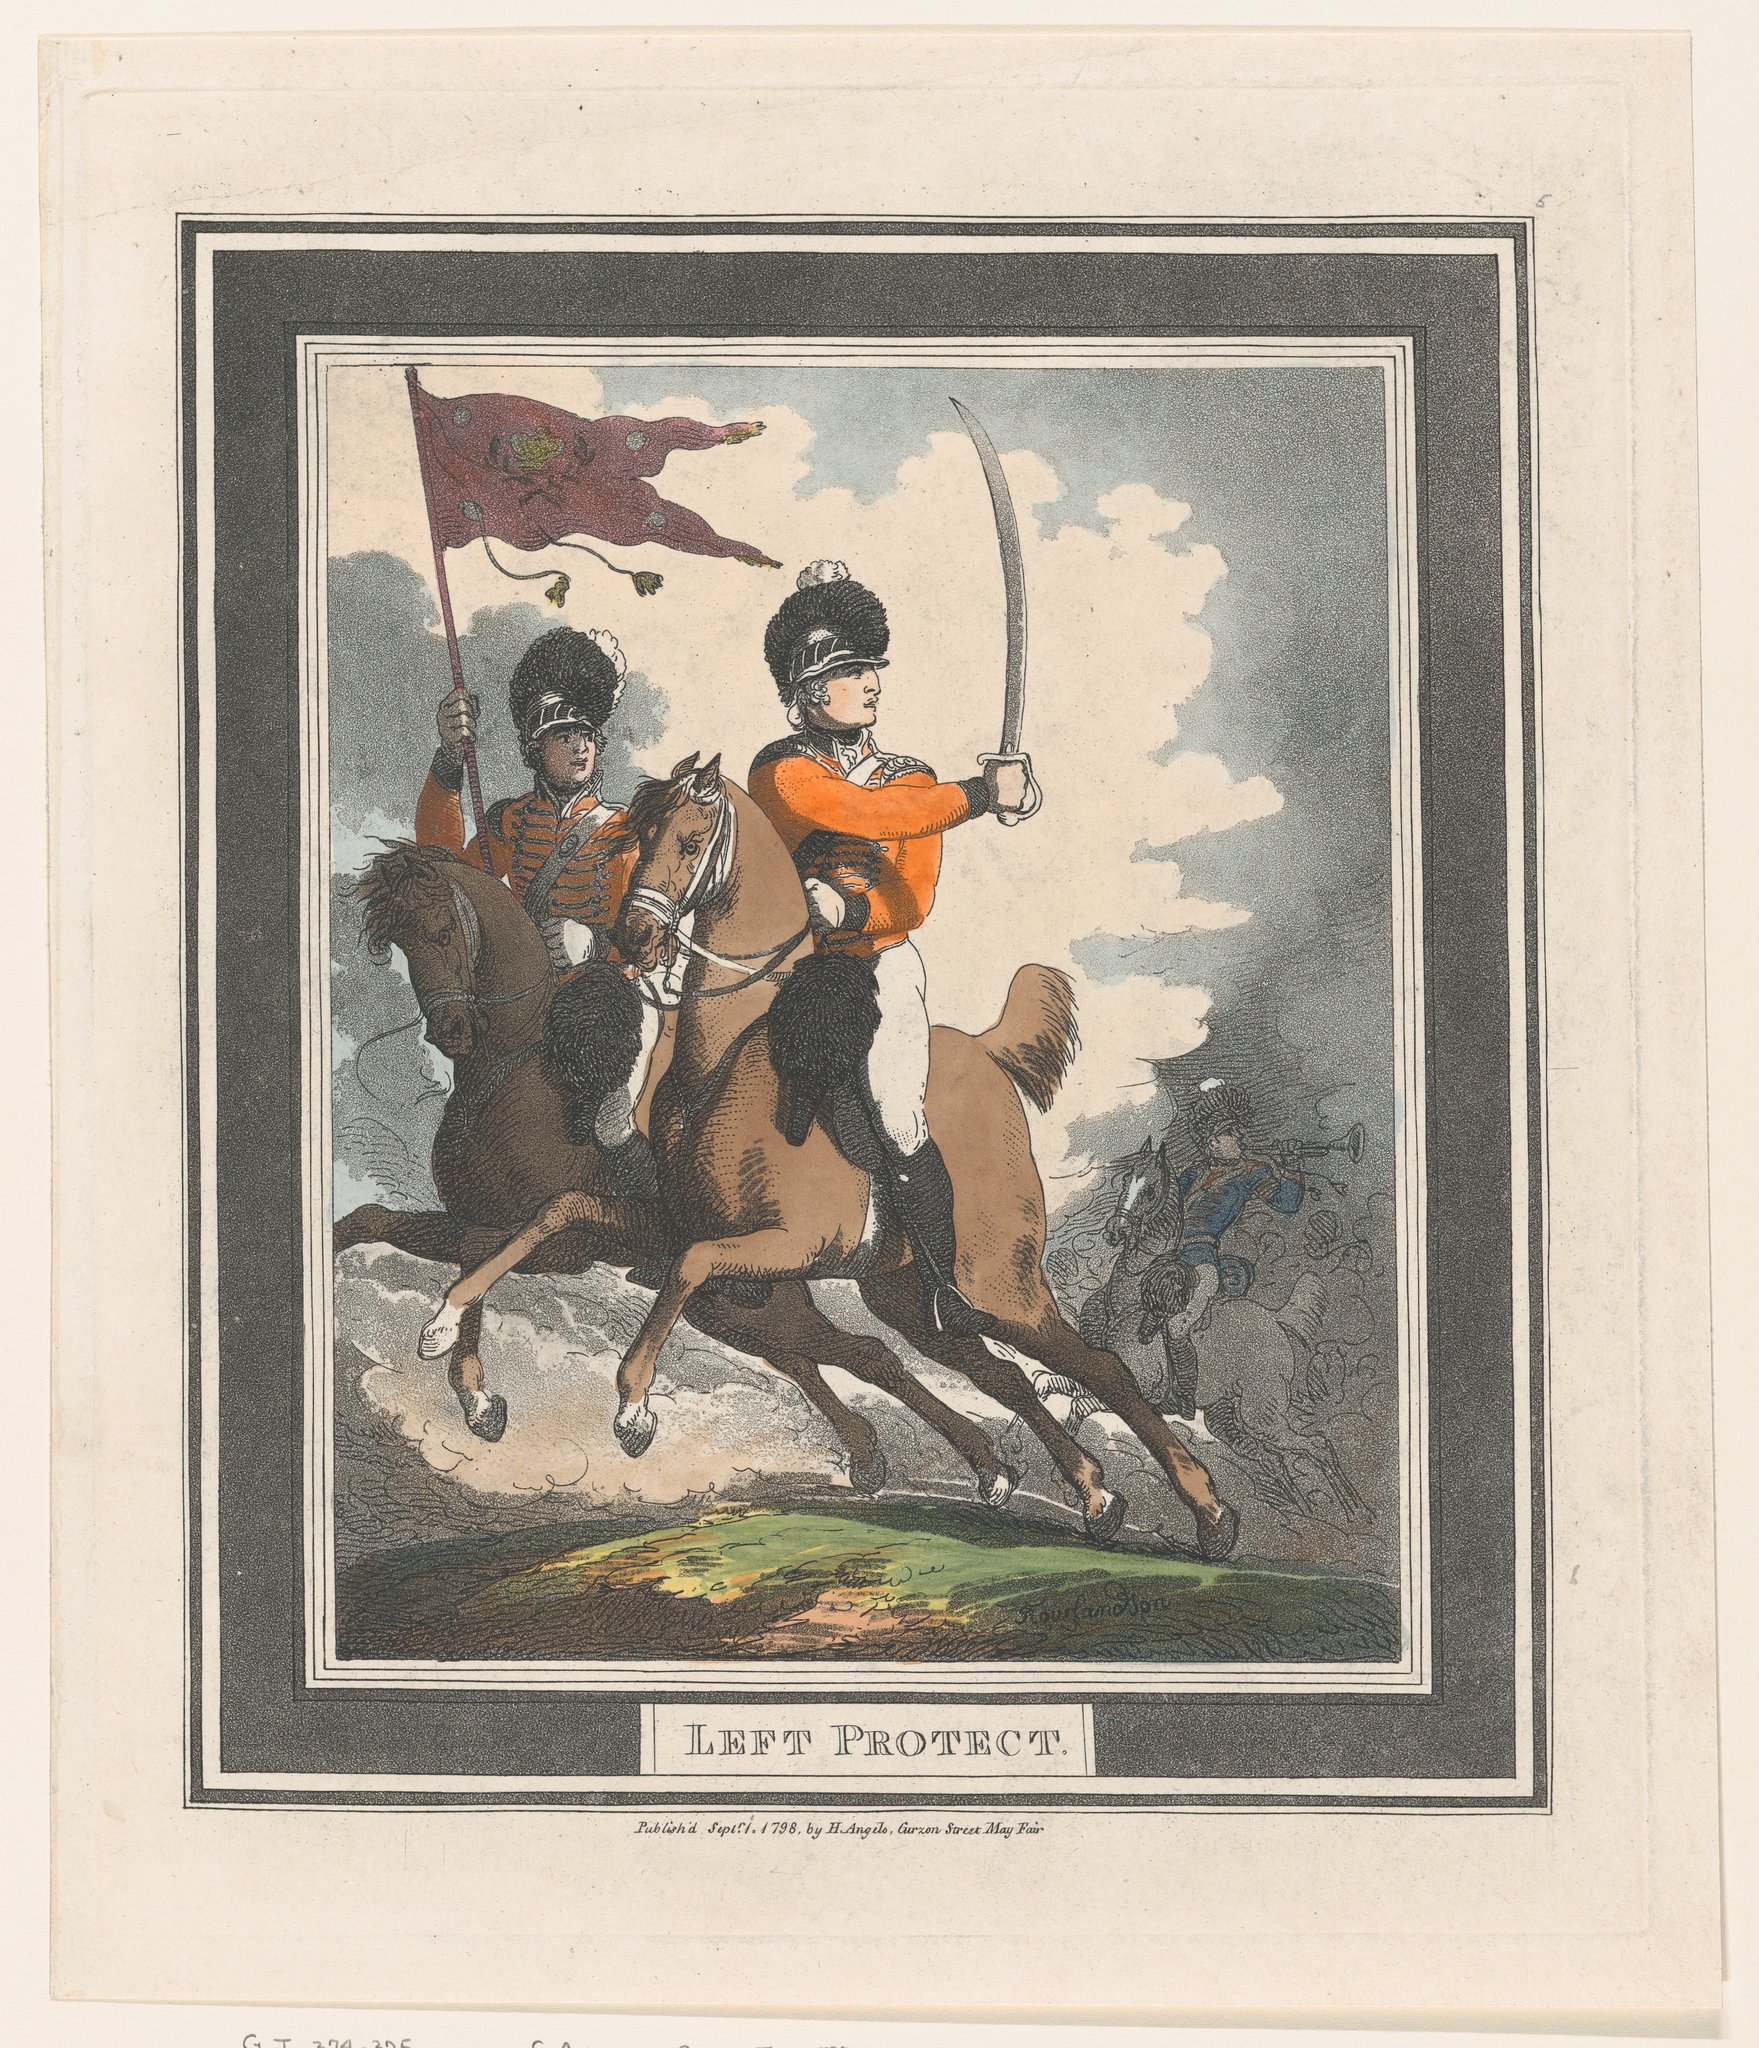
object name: print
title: Left Protect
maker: thomas rowlandson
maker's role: artist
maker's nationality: british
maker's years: 1757-1827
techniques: aquatint, etching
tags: soldiers,men,horses,flags